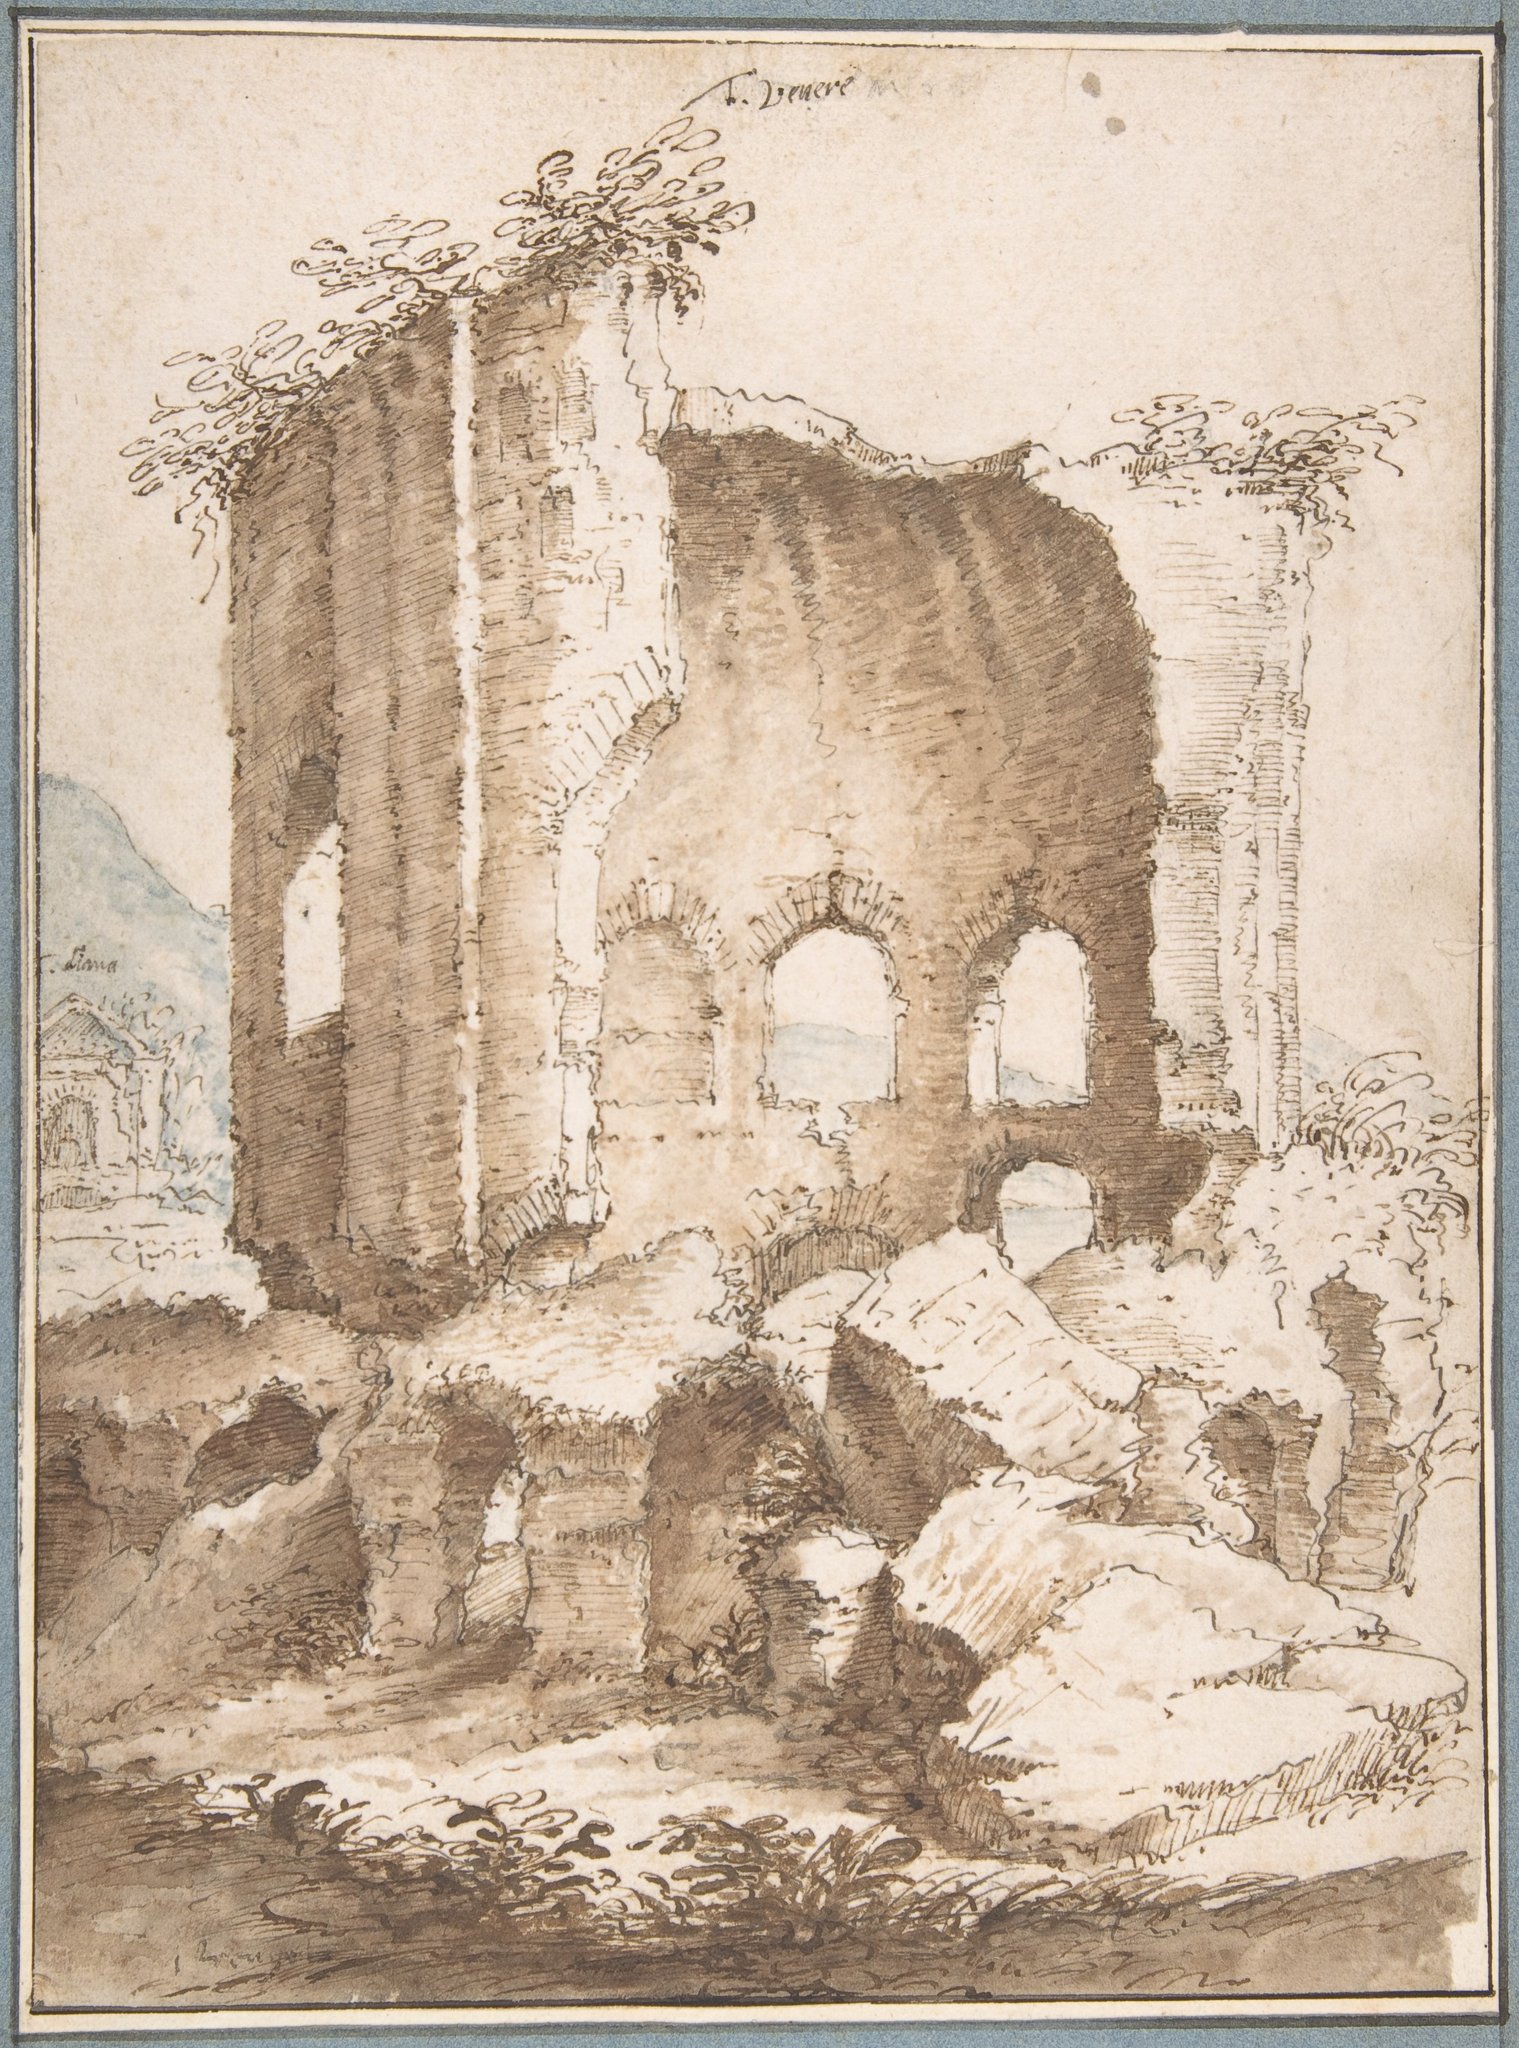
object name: drawing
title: View of the Temples of Venus and of Diana in Baia from the South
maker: jan brueghel the elder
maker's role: artist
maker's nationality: netherlandish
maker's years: 1568-1625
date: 1594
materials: chalk, ink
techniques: brush, pen, wash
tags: temples,ruins